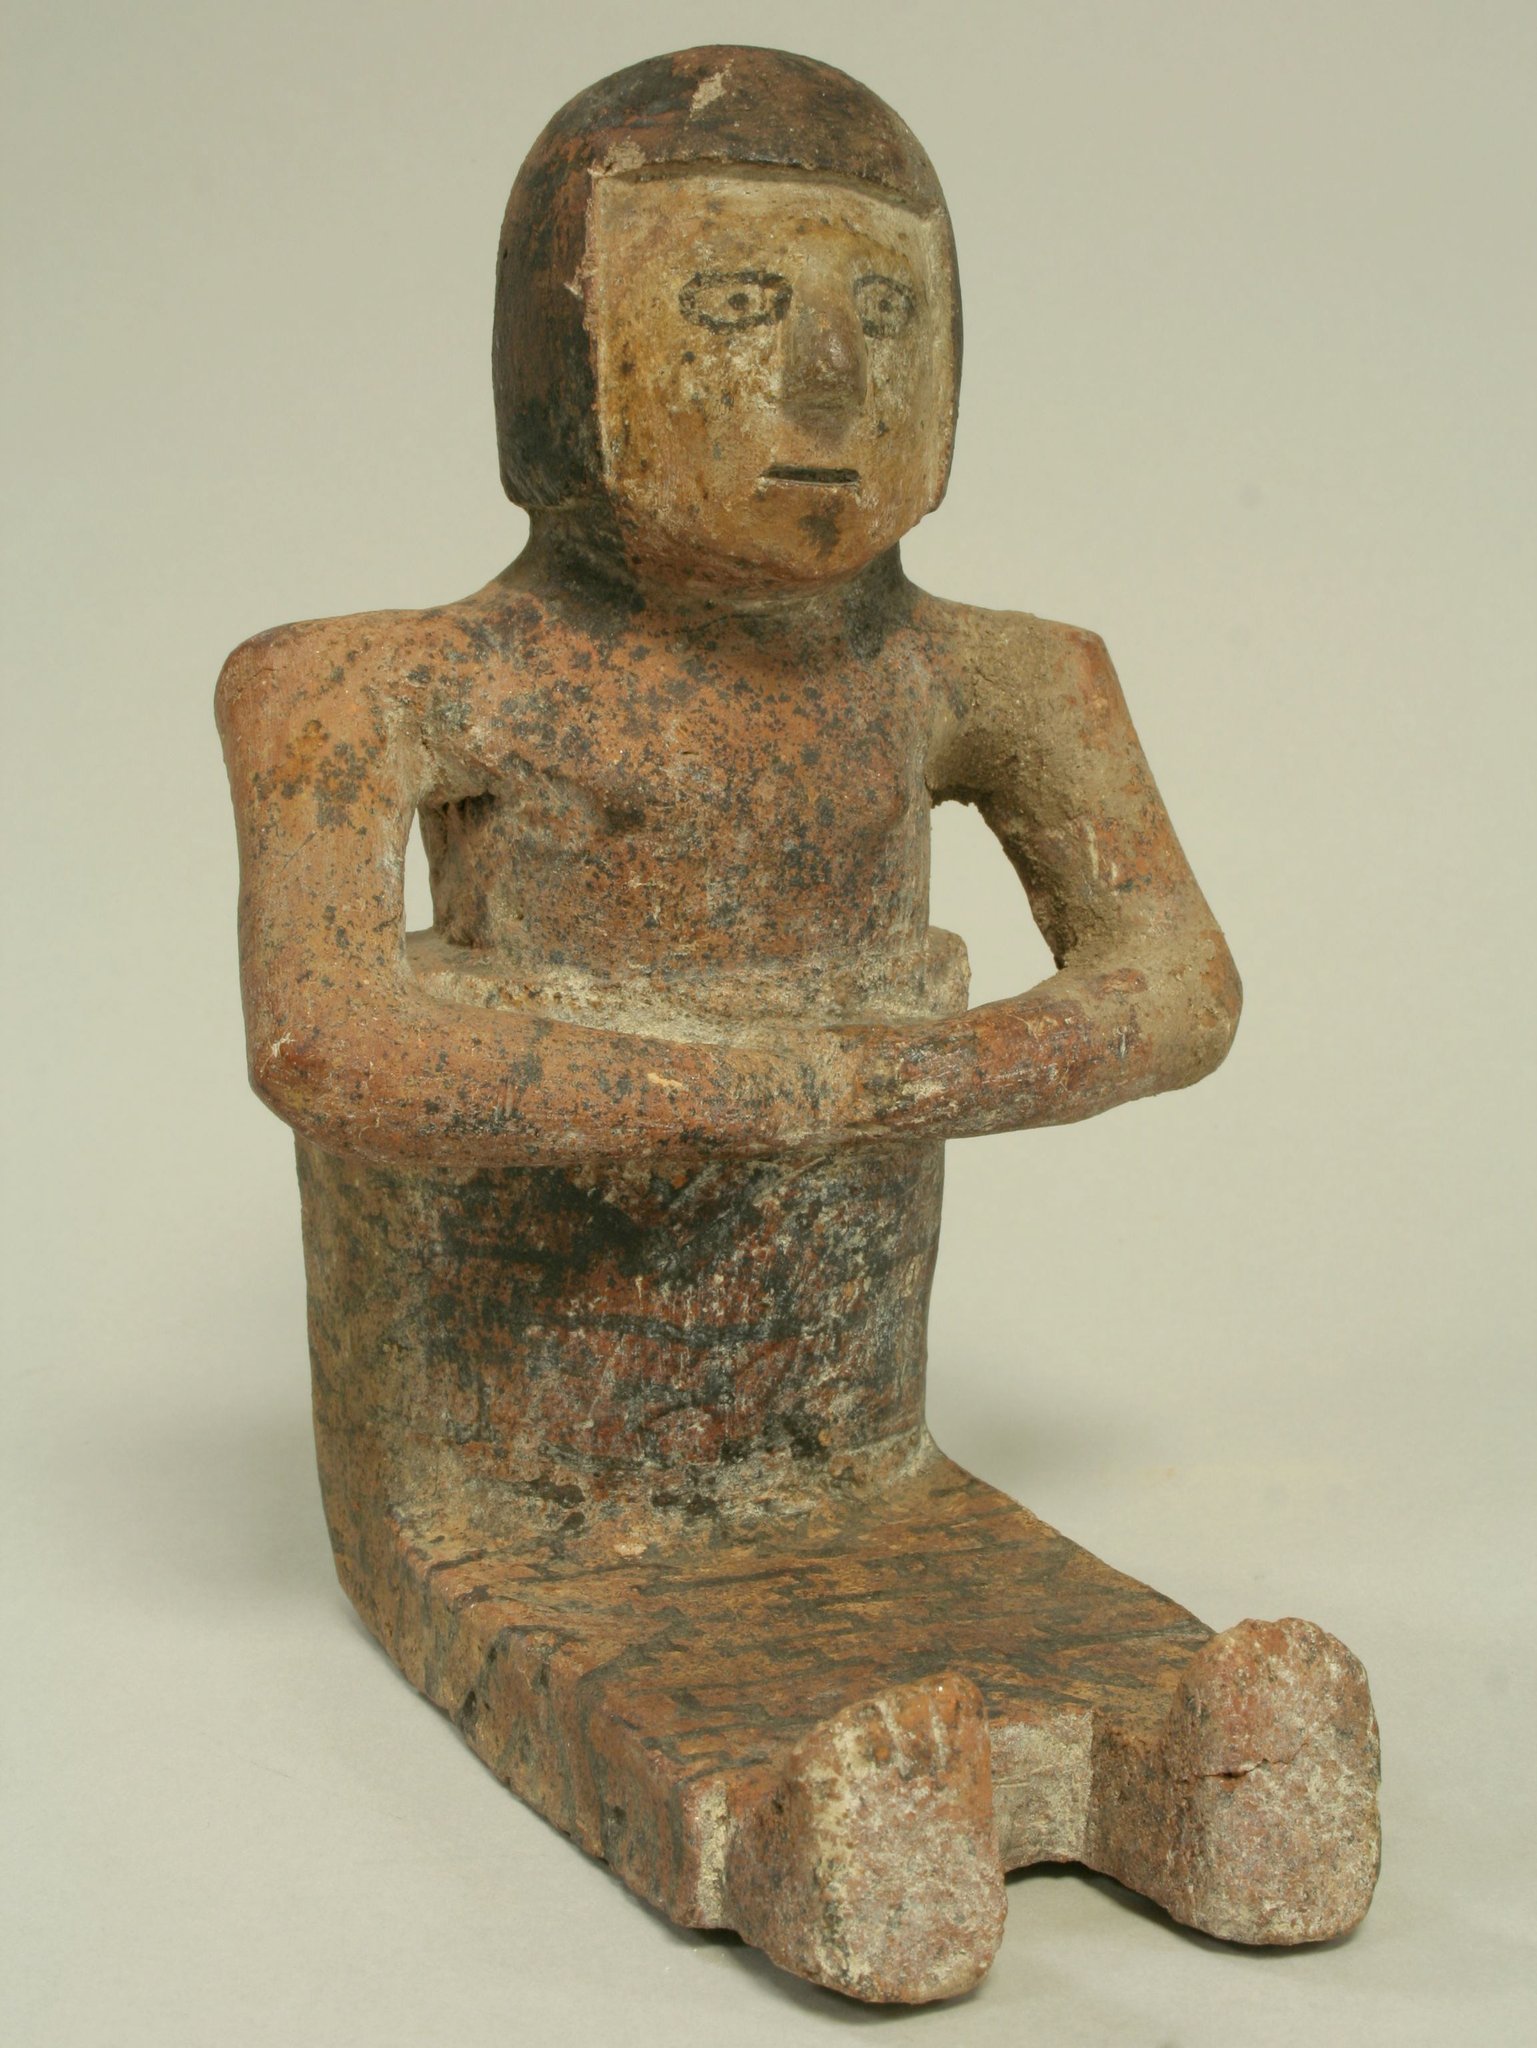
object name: figure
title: Ceramic Seated Female Figure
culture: carchi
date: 1001-1600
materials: ceramic, pigment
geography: ecuador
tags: women